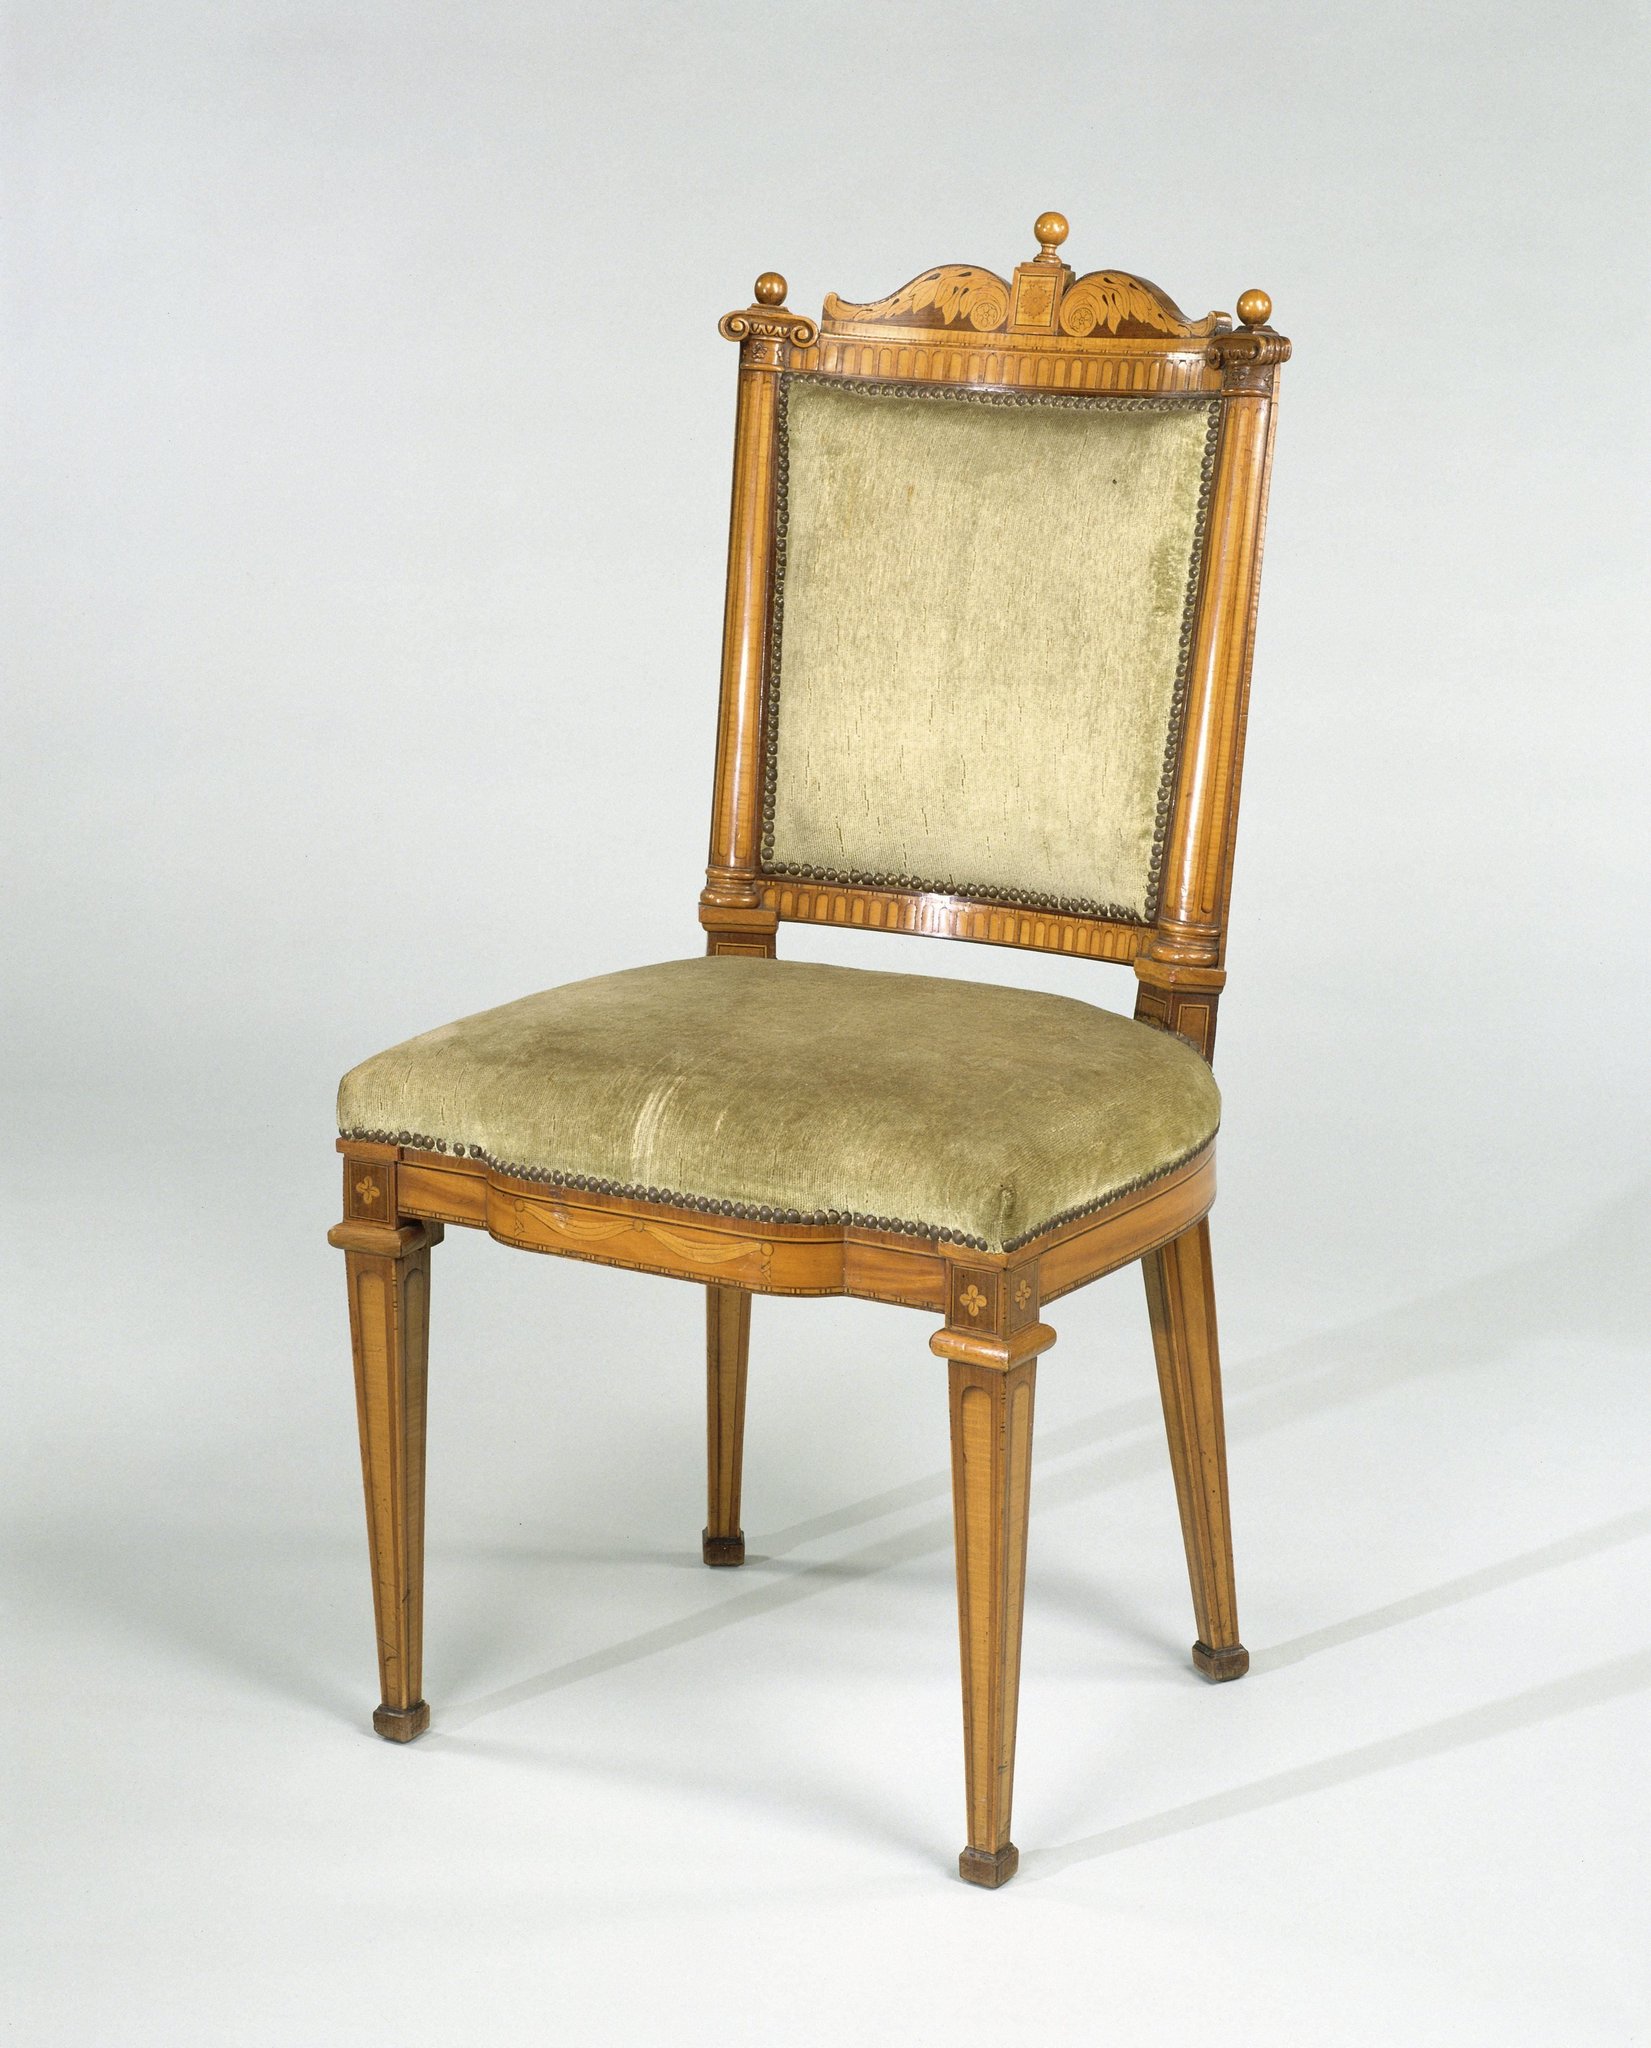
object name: chair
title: Stoel van iepenhout, met uitzondering van de achterzijde geheel versierd met marqueteriewerk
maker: Anonymous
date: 1780-1790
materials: wood, textile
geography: netherlands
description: Six chairs. Elm, veneered with sycamore, tulipwood, purplewood, mahogany and other woods. Netherlands, c. 1780 - 1790.